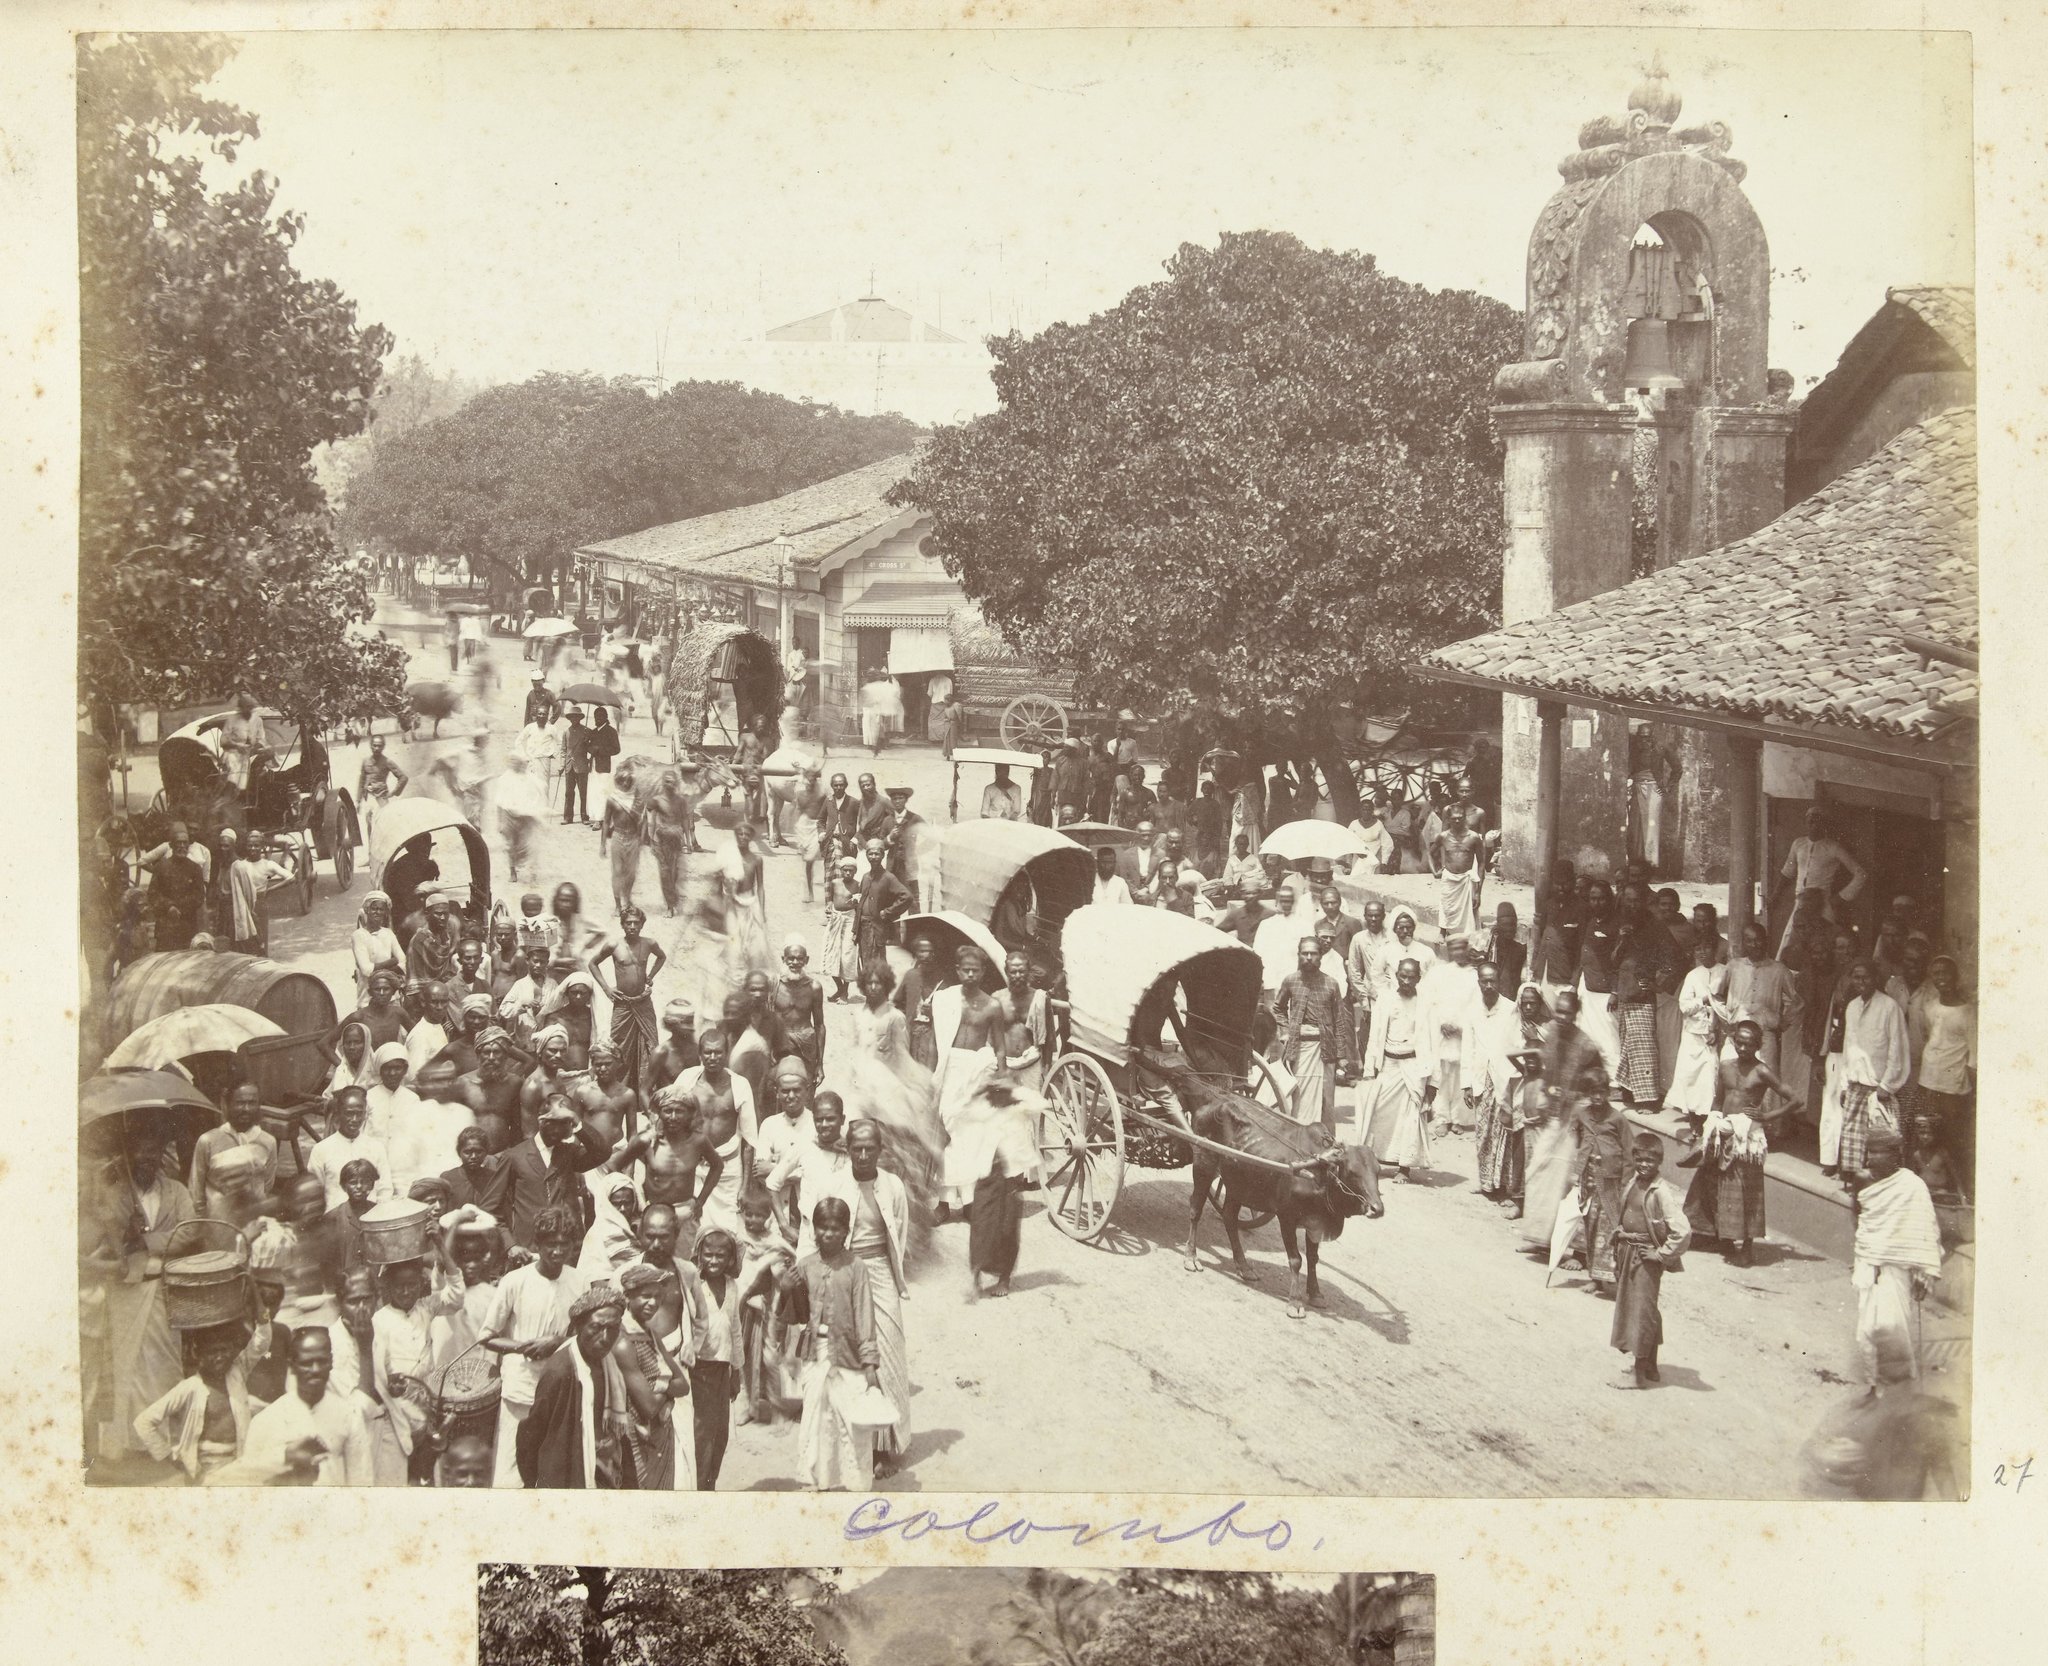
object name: photograph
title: The Old Belfry in Pettah, Colombo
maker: Anonymous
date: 1890-1910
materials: cardboard, paper, photographic support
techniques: gelatin silver print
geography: netherlands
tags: colombo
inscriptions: caption: ‘Colombo’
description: Drukke straat met veel verkeer waaronder ossen en paarden karren